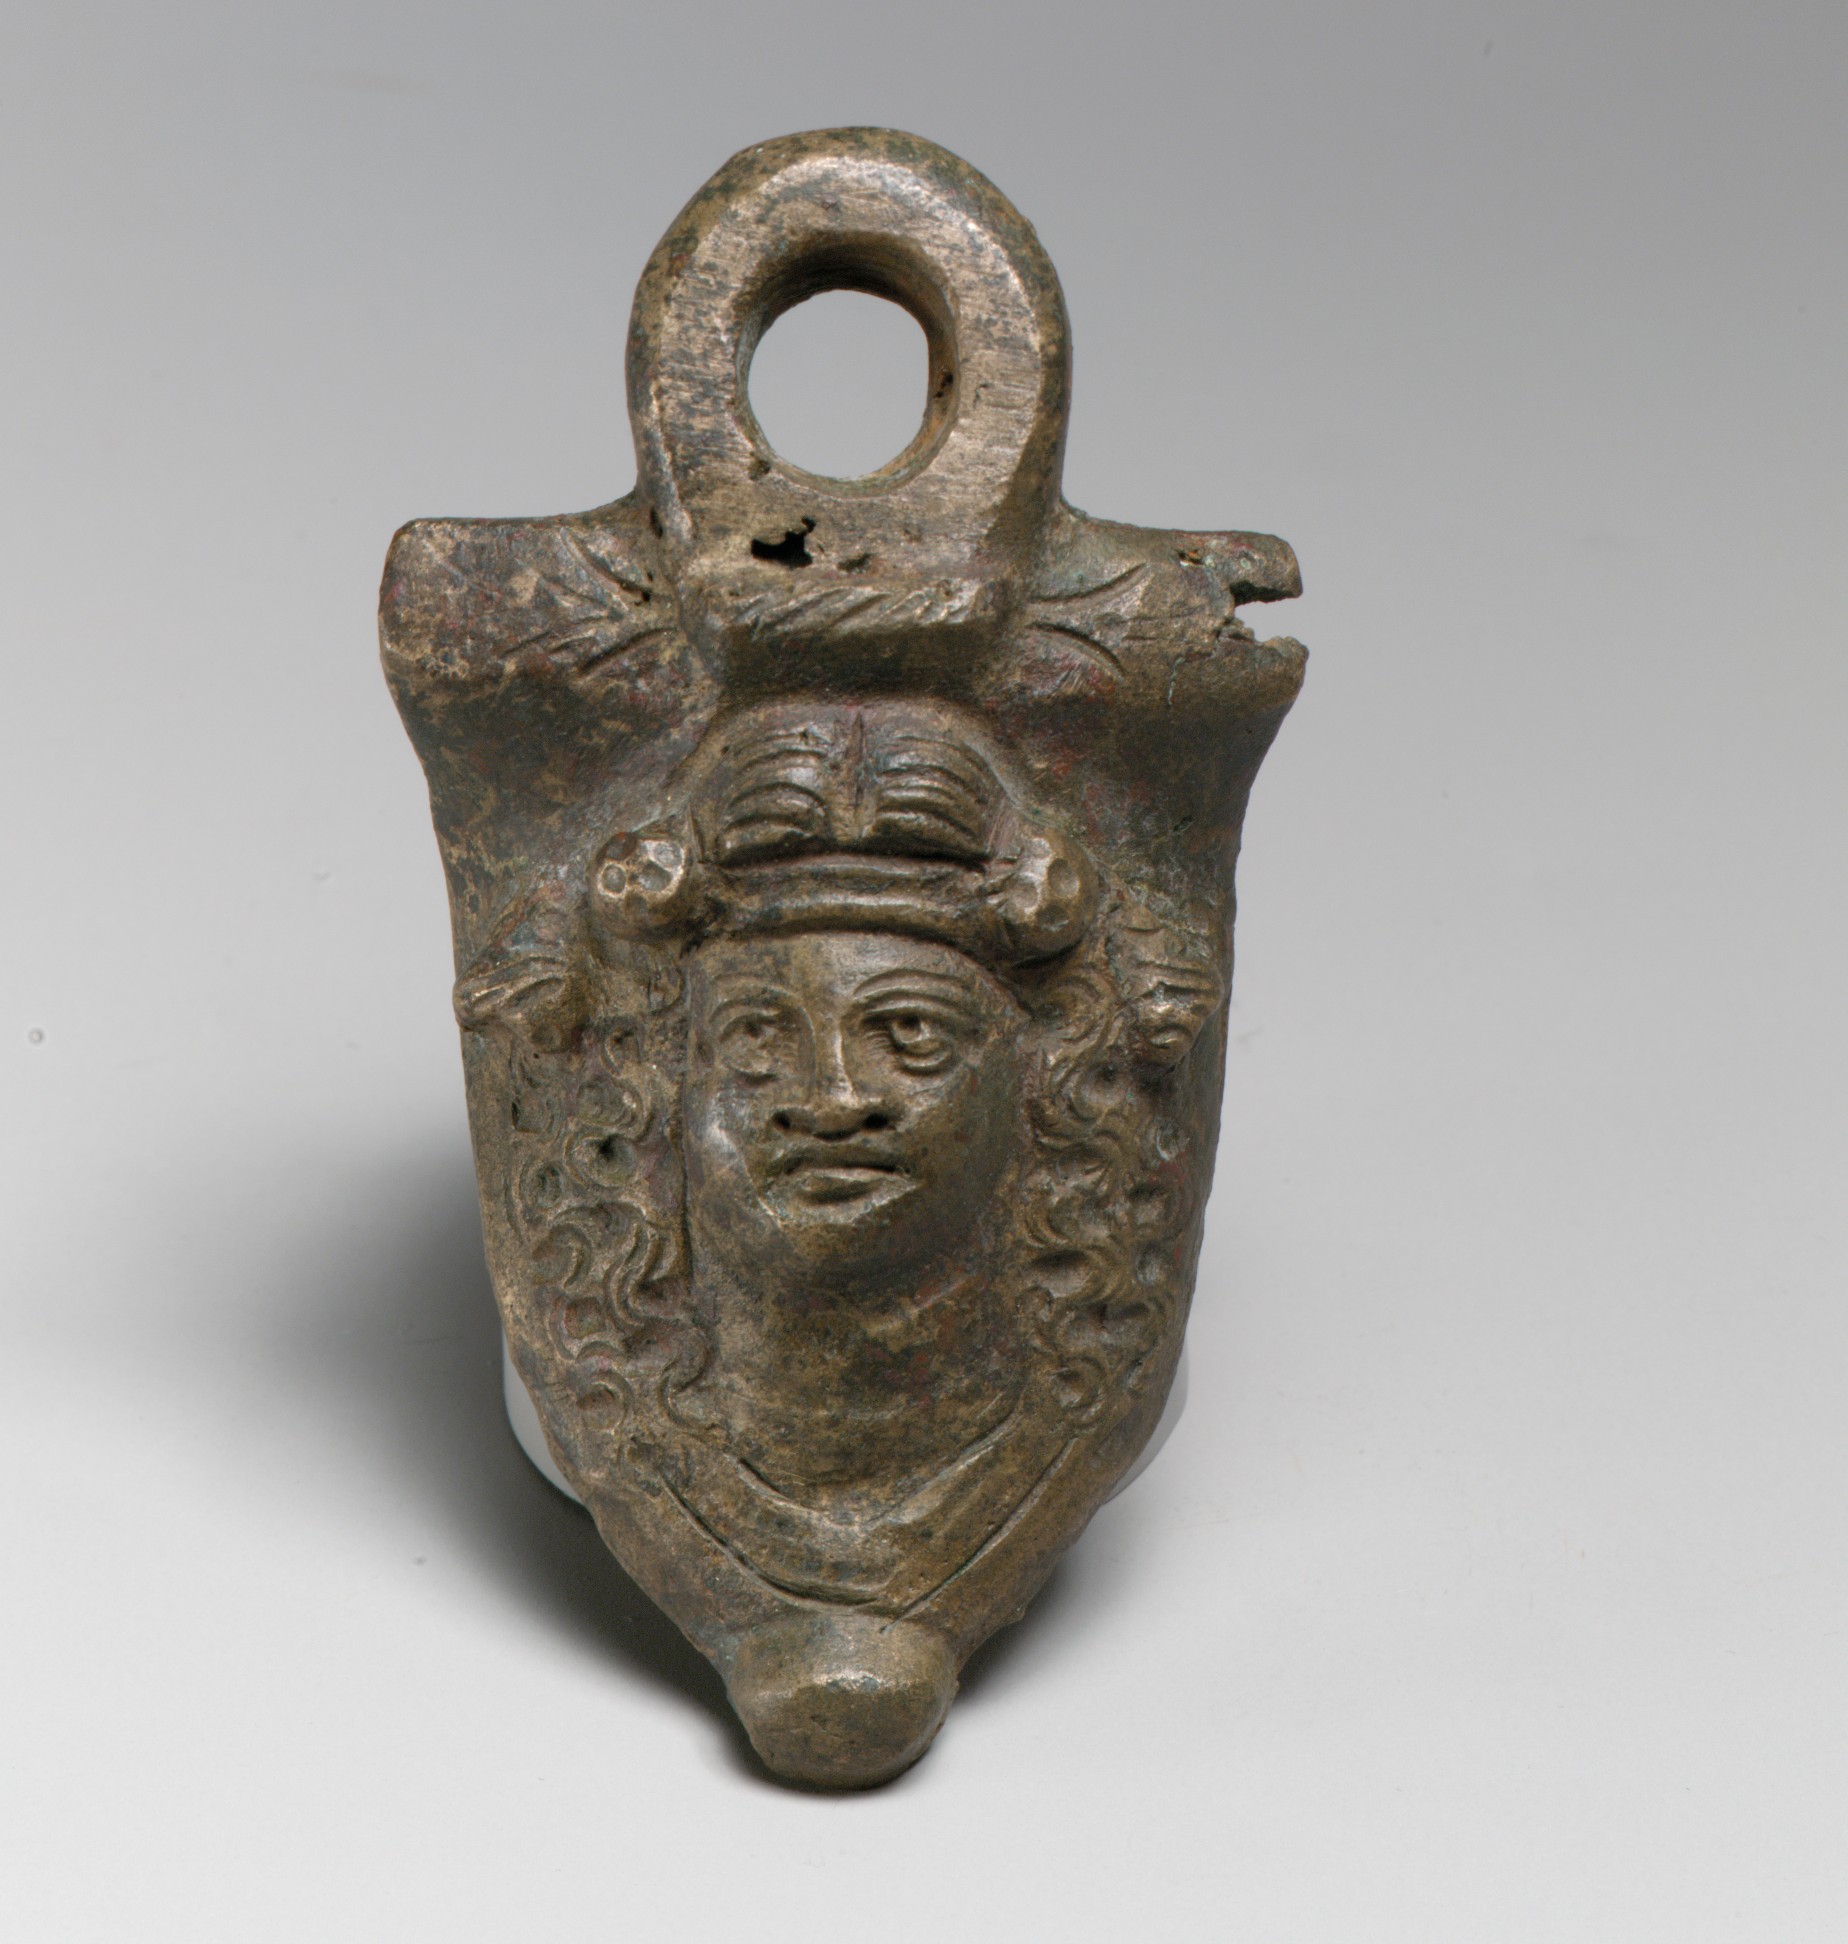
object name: handle attachment for a situla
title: Bronze handle attachment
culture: roman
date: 101-200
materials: bronze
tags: faces